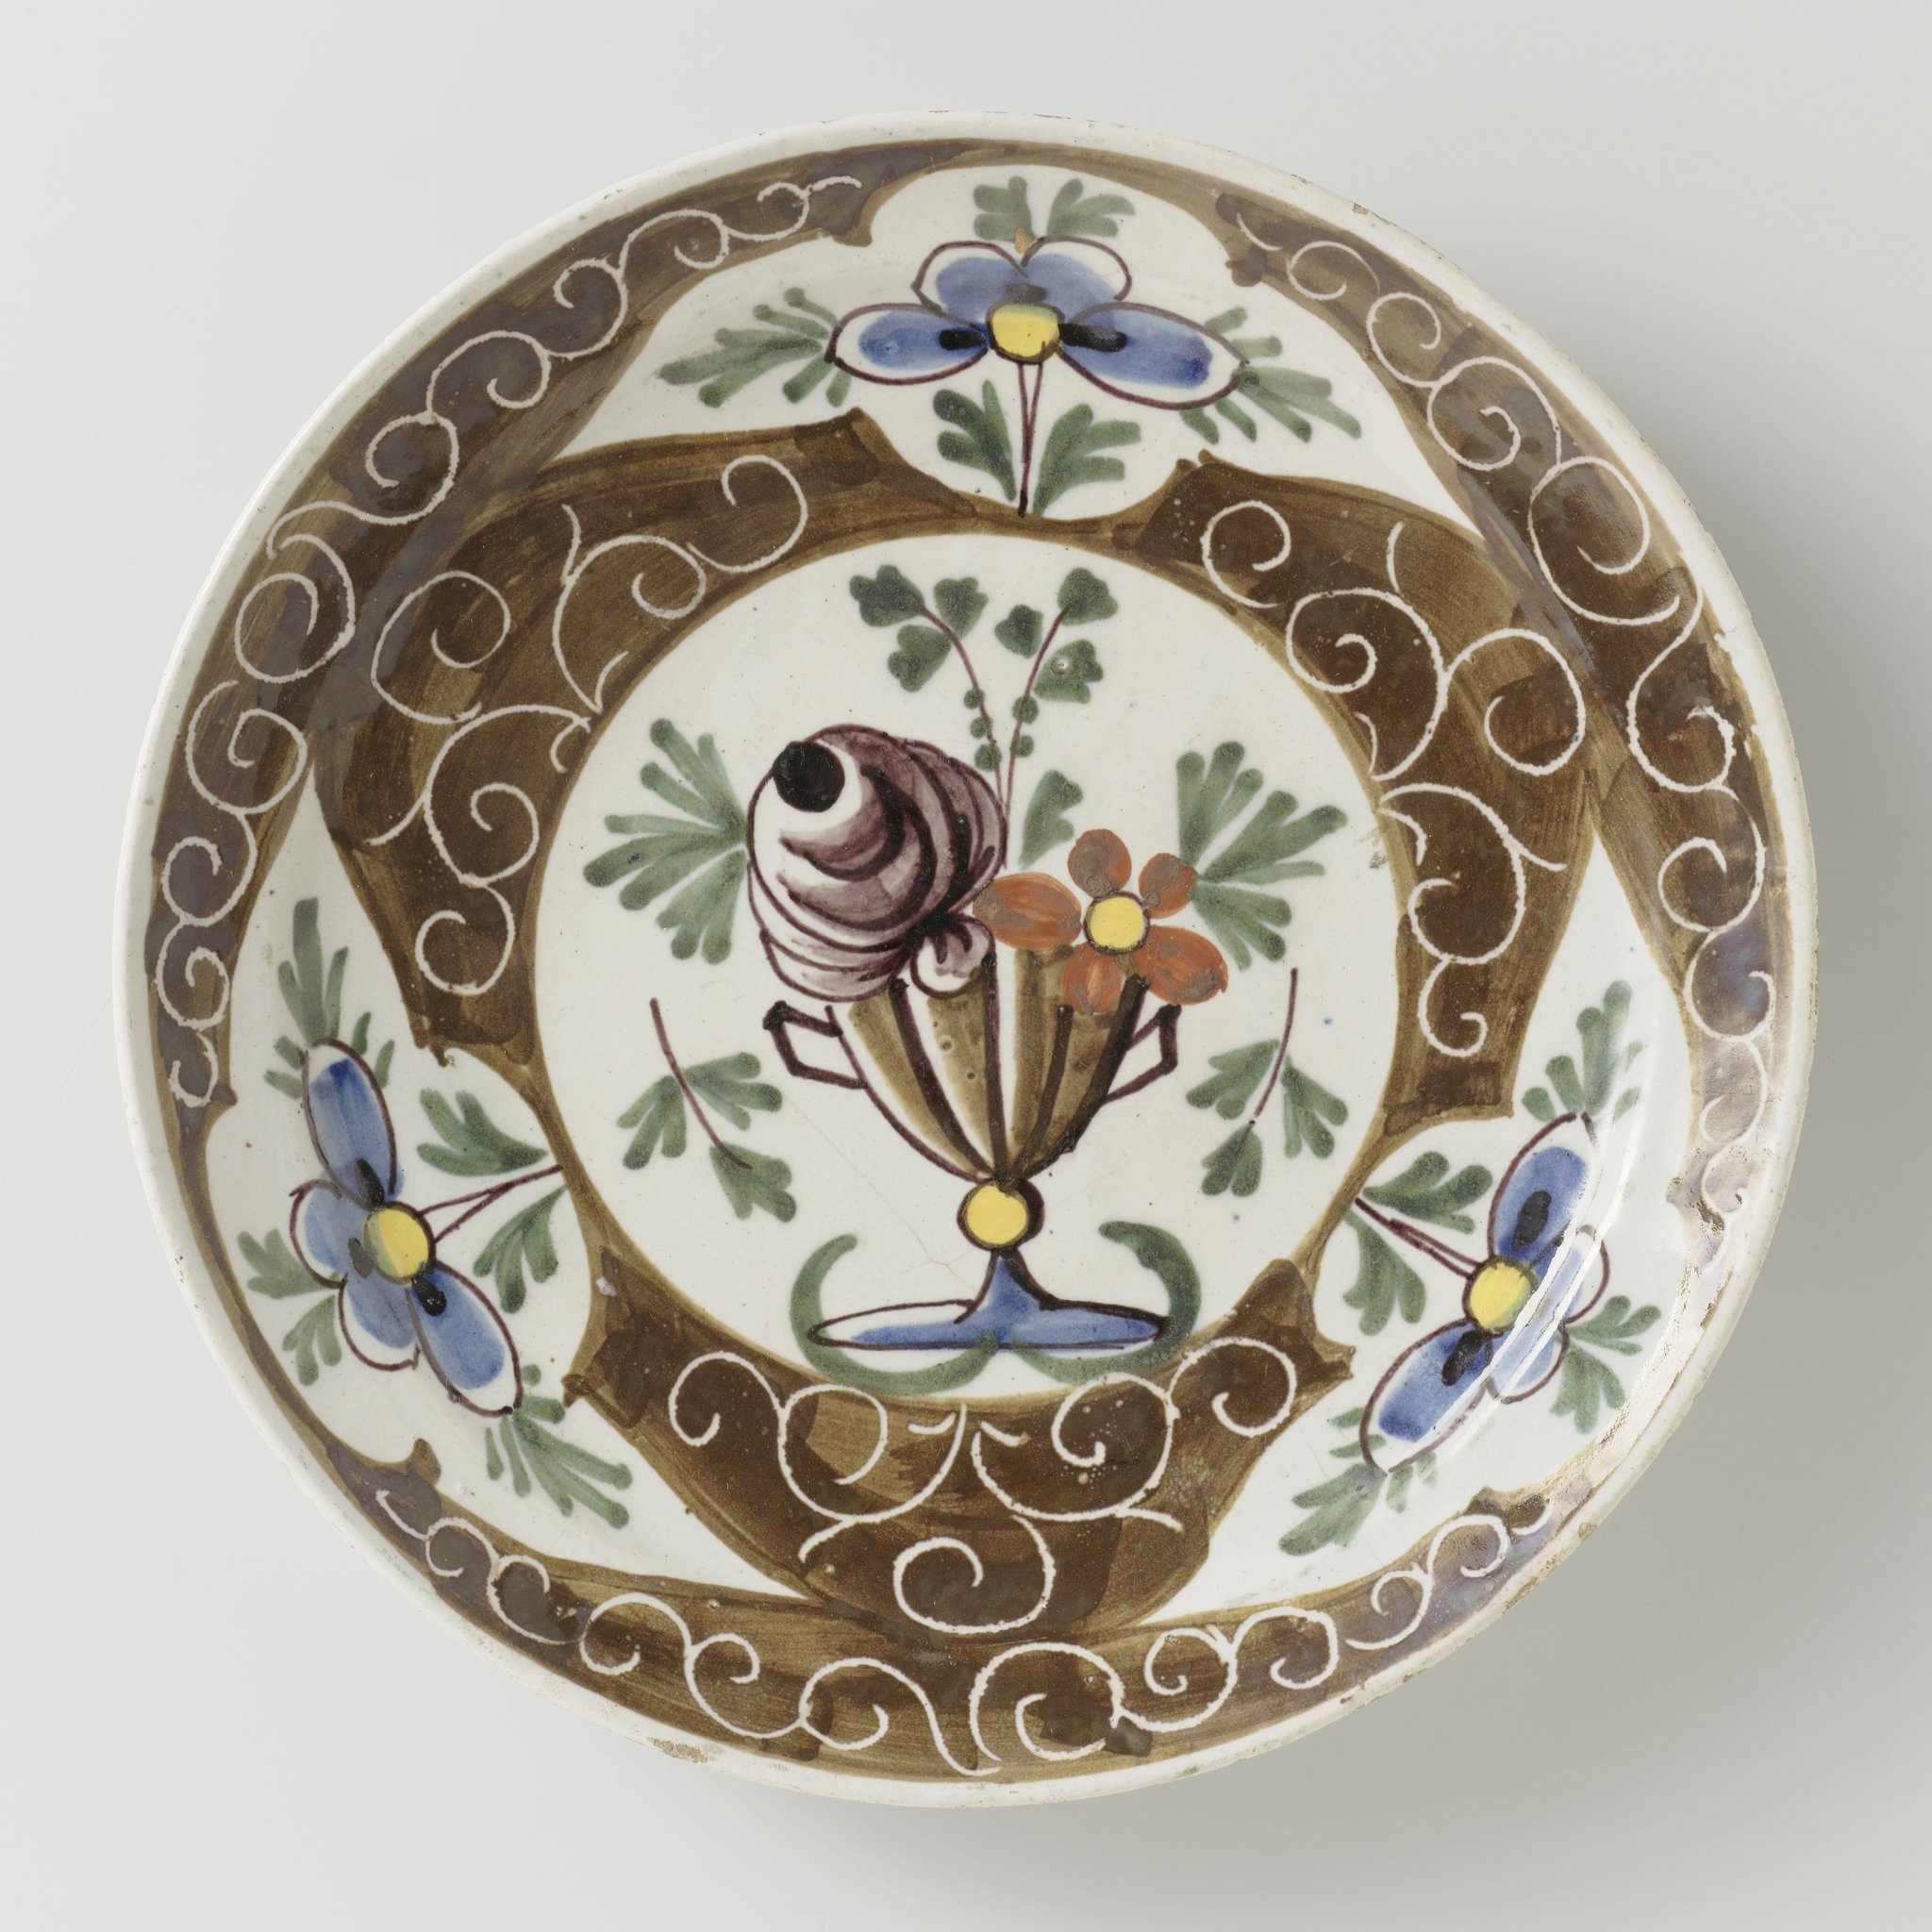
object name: plate dish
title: Bord van faience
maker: Anonymous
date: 1780-1820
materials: faience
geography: delft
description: Bord van faience veelkleurig beschilderd met een vaas met bloemen en een gedecoreerde rand.